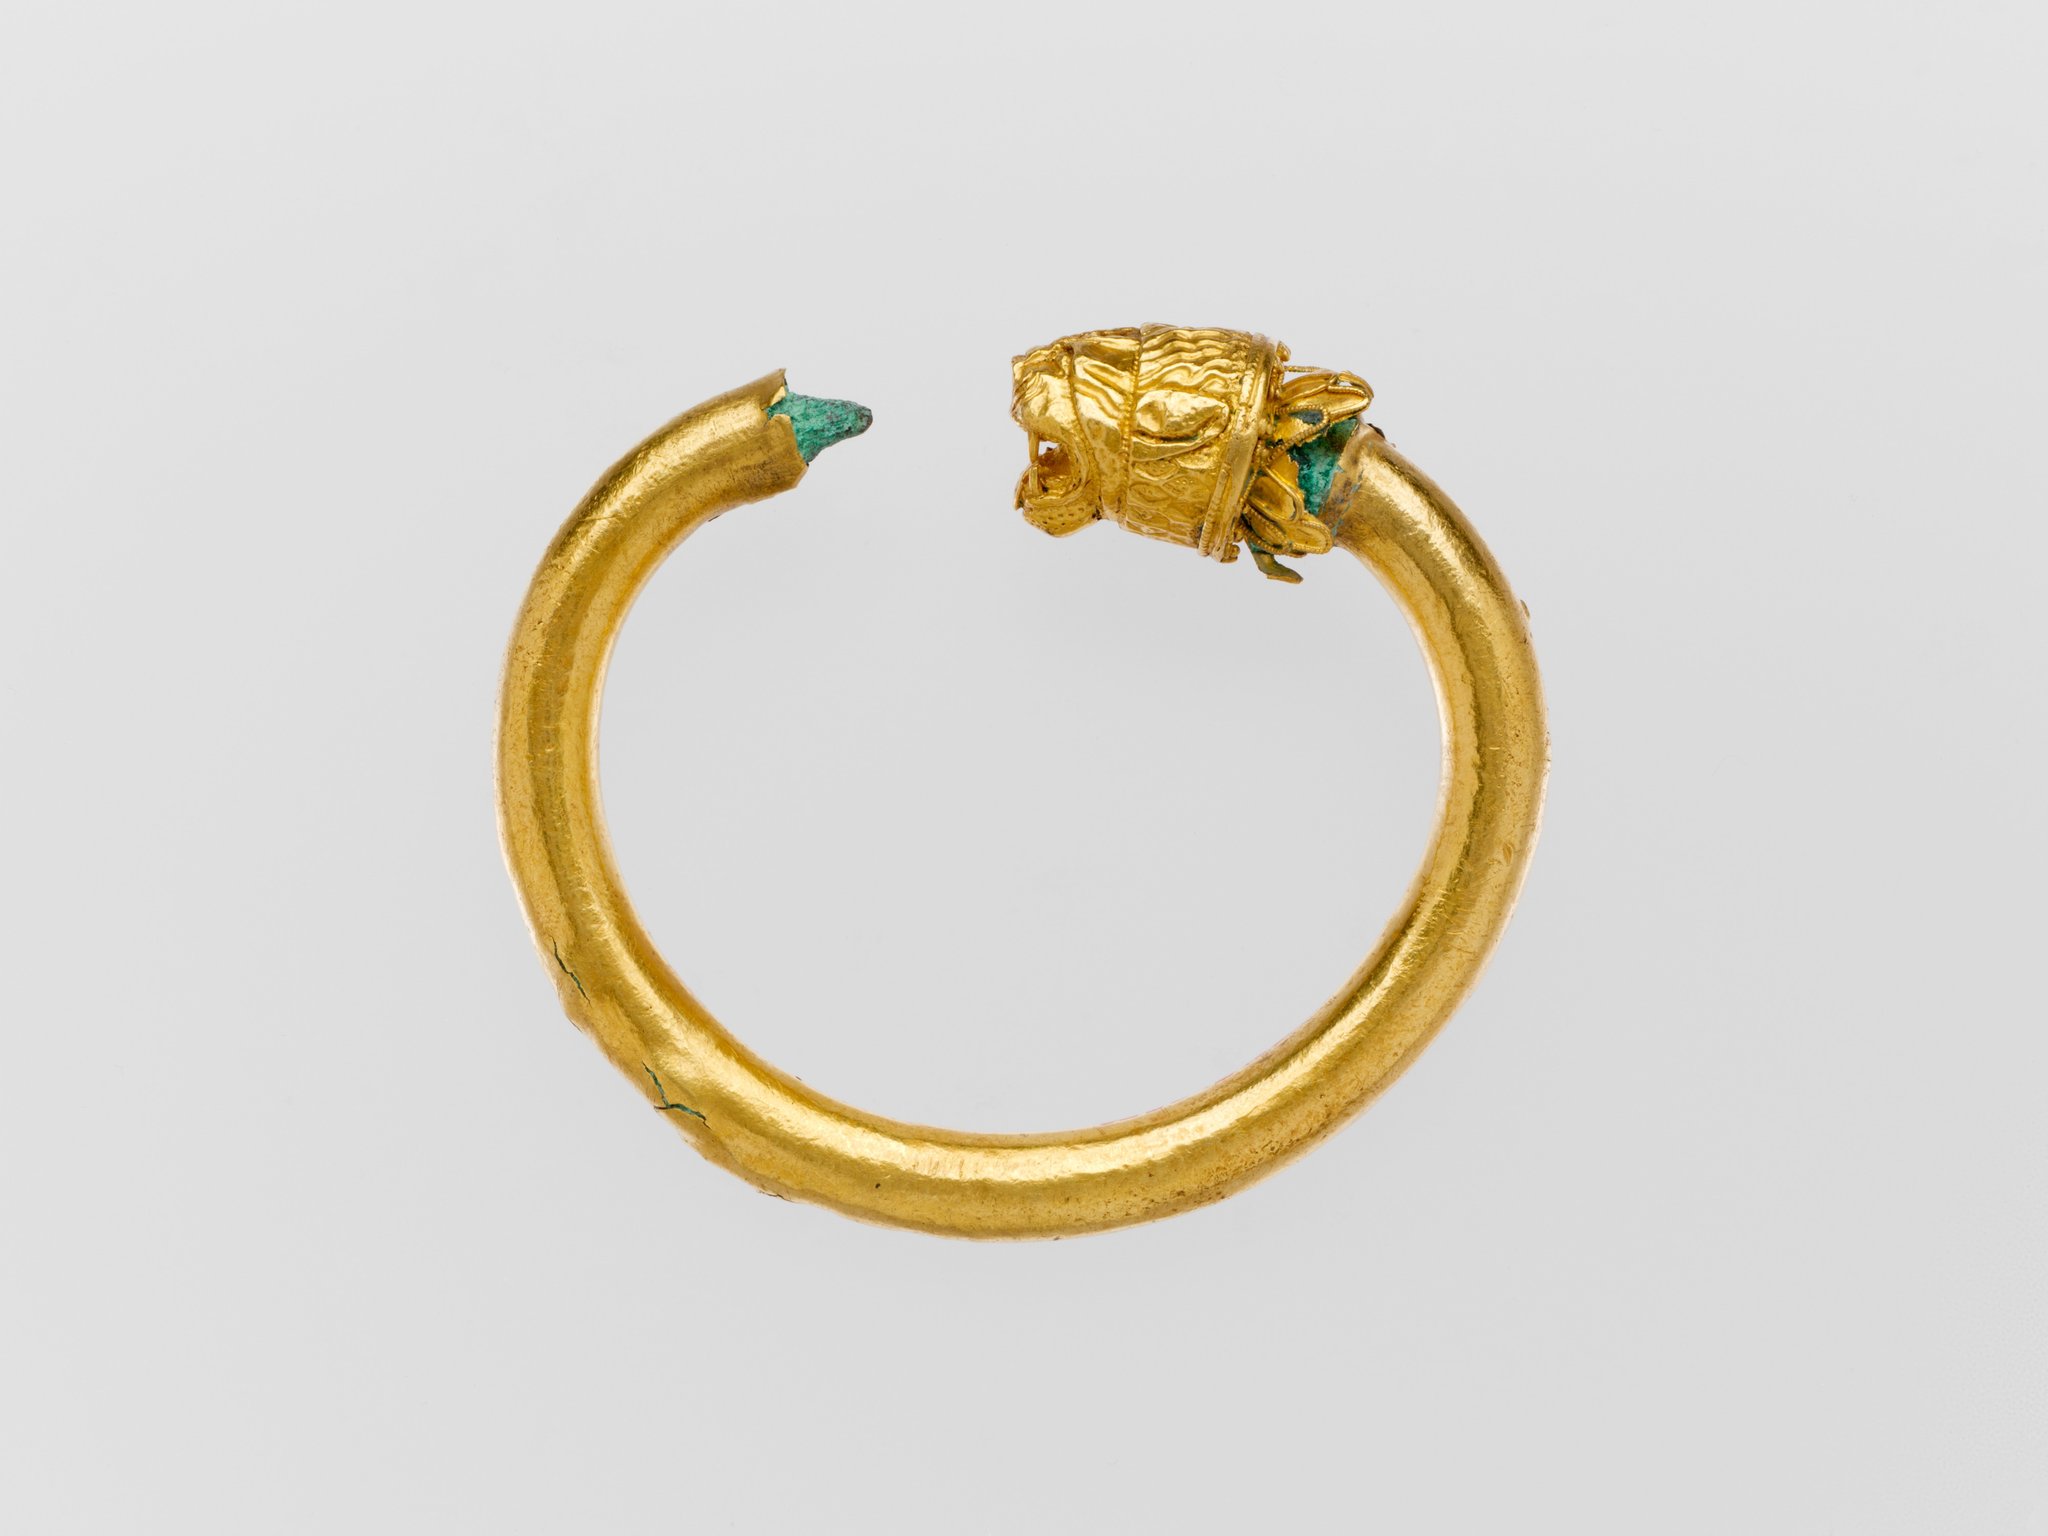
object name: bracelet, gilded bronze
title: Gold and copper alloy bracelet with lion-head finials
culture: cypriot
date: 500-401 BCE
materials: bronze, gold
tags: lions